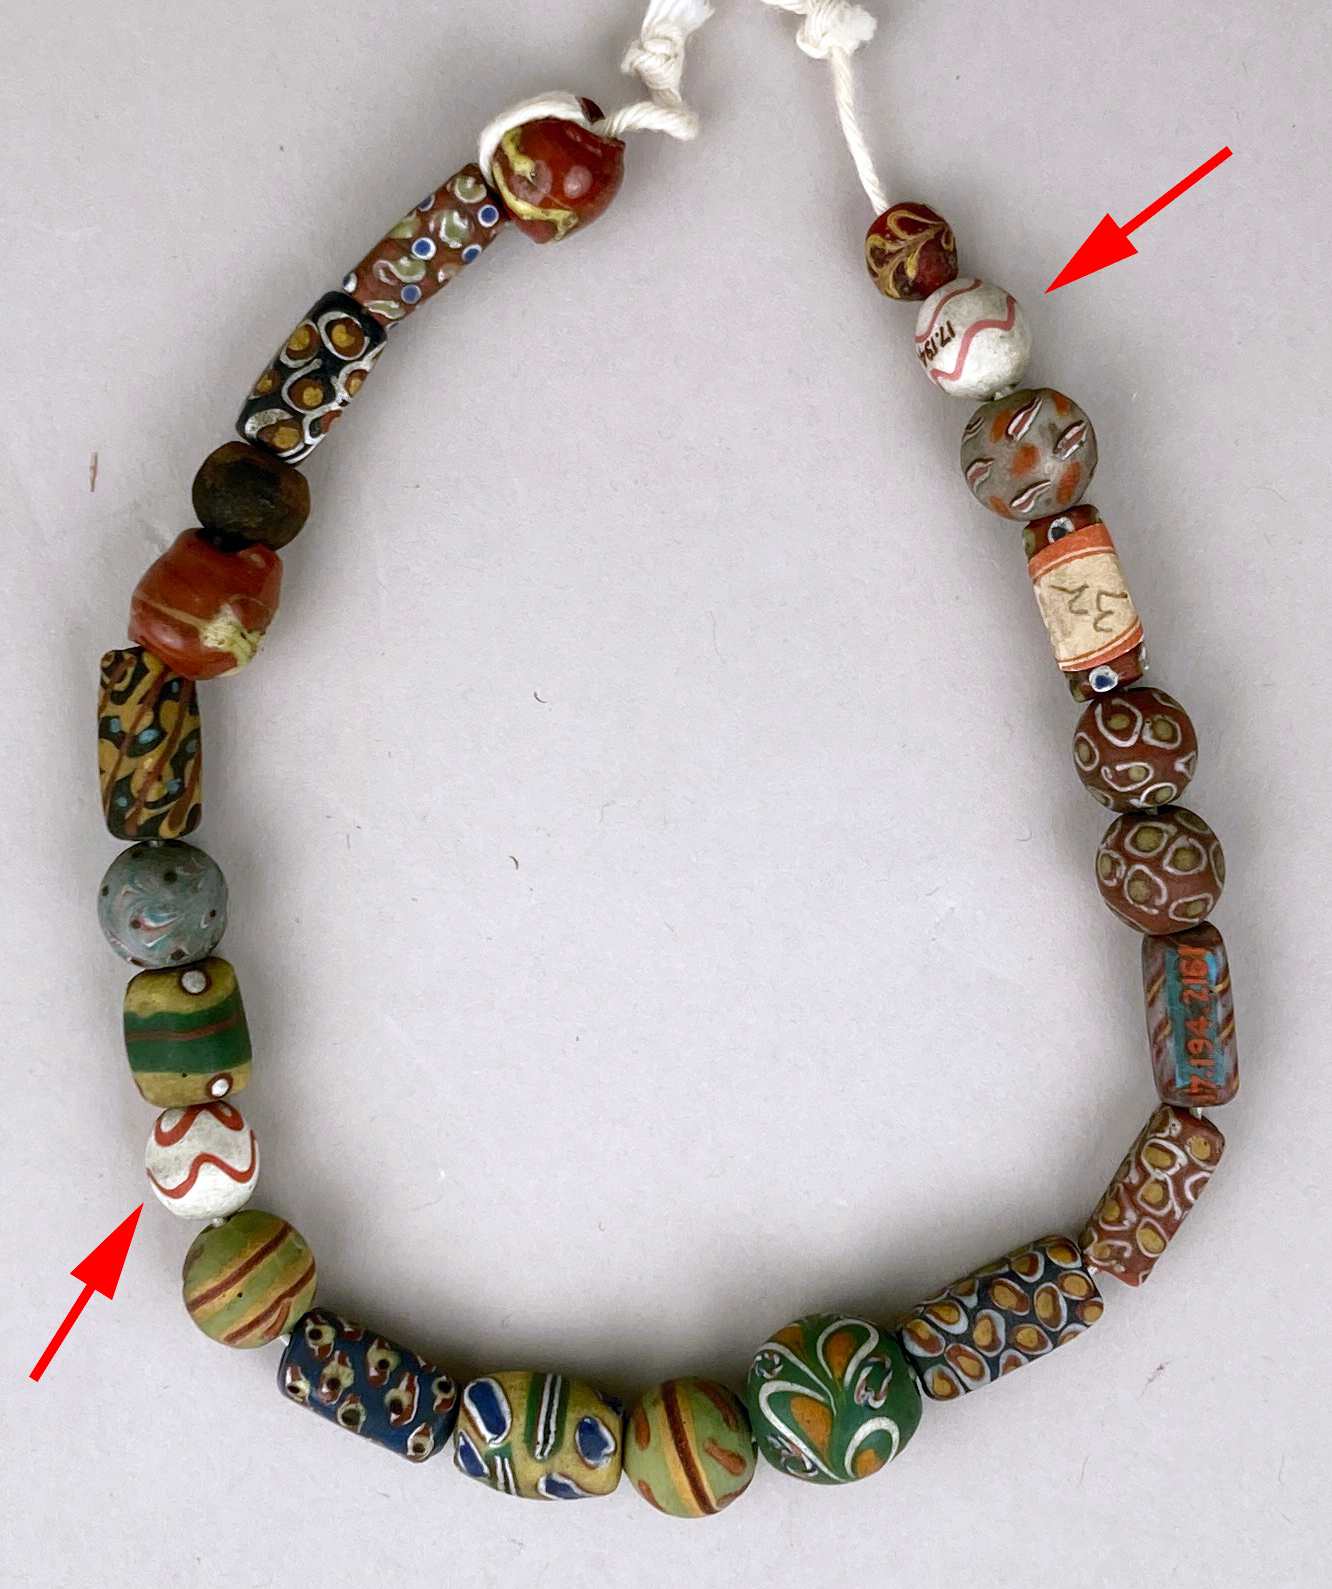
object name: bead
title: Beads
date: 1801-1900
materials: glass